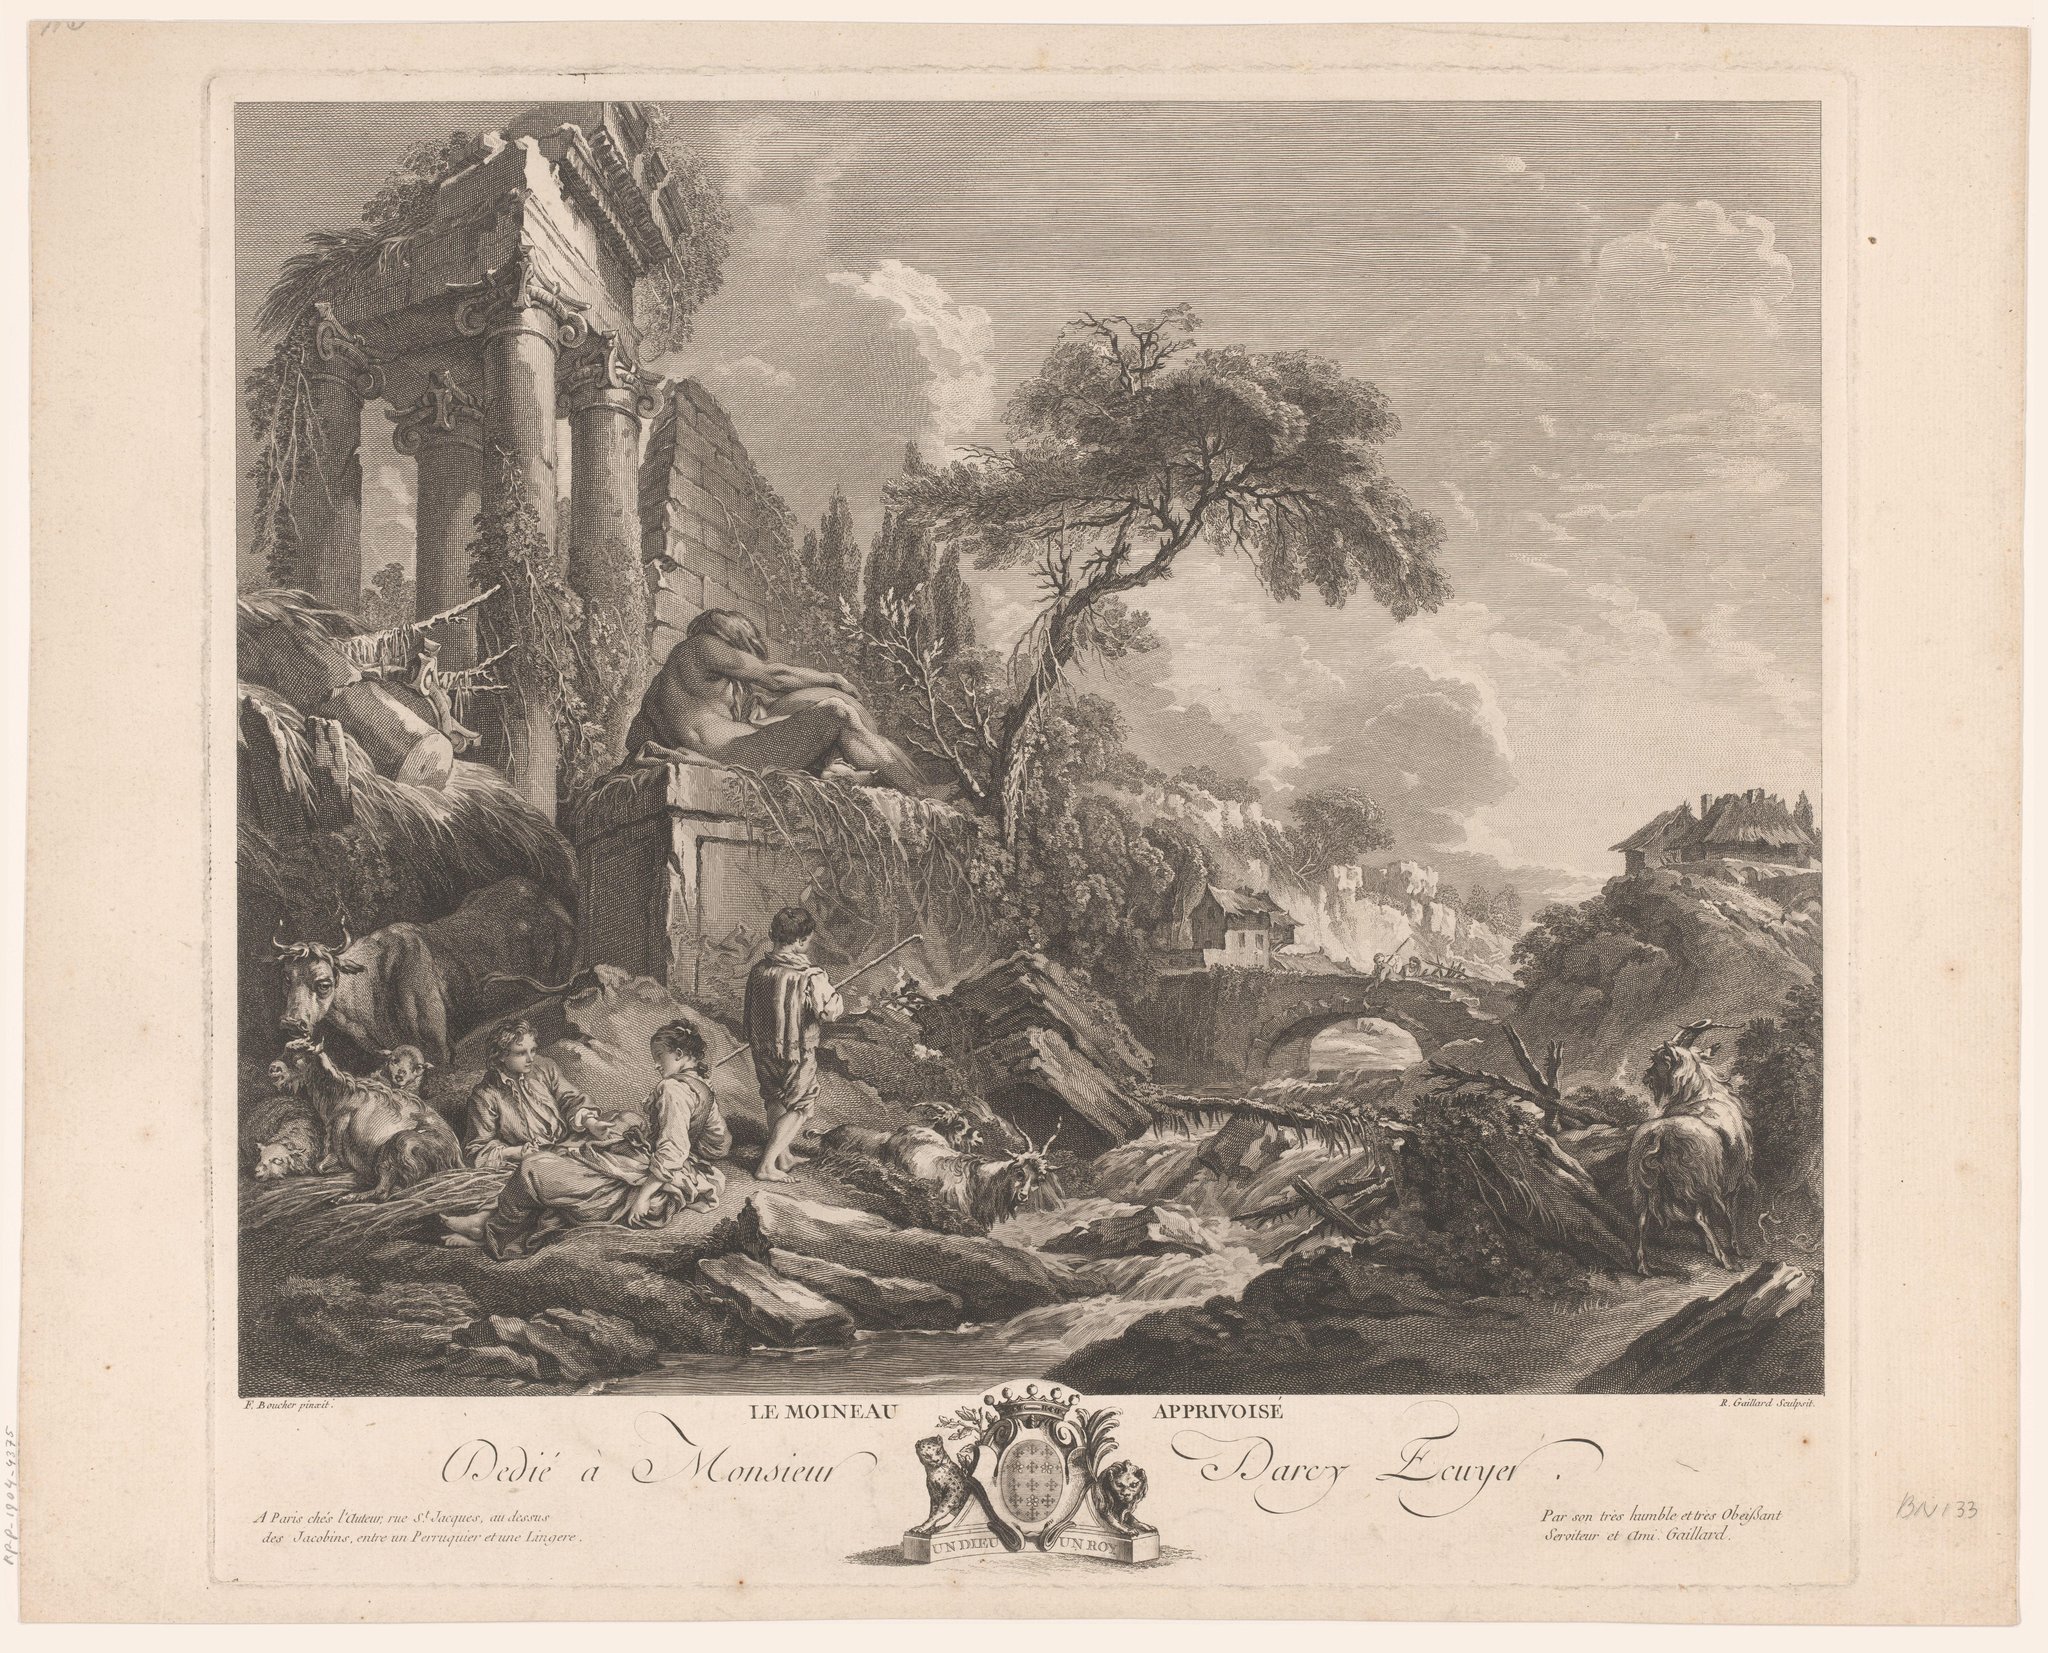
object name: print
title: Rustende herders in een rivierlandschap met ruïnes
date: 1729-1790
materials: paper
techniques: engraving, etching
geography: paris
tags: herding, herdsman, herdswoman, shepherd, shepherdess, cowherd, etc., landscape with ruins, resting - bb - out of doors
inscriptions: collector's mark: Lugt 2228